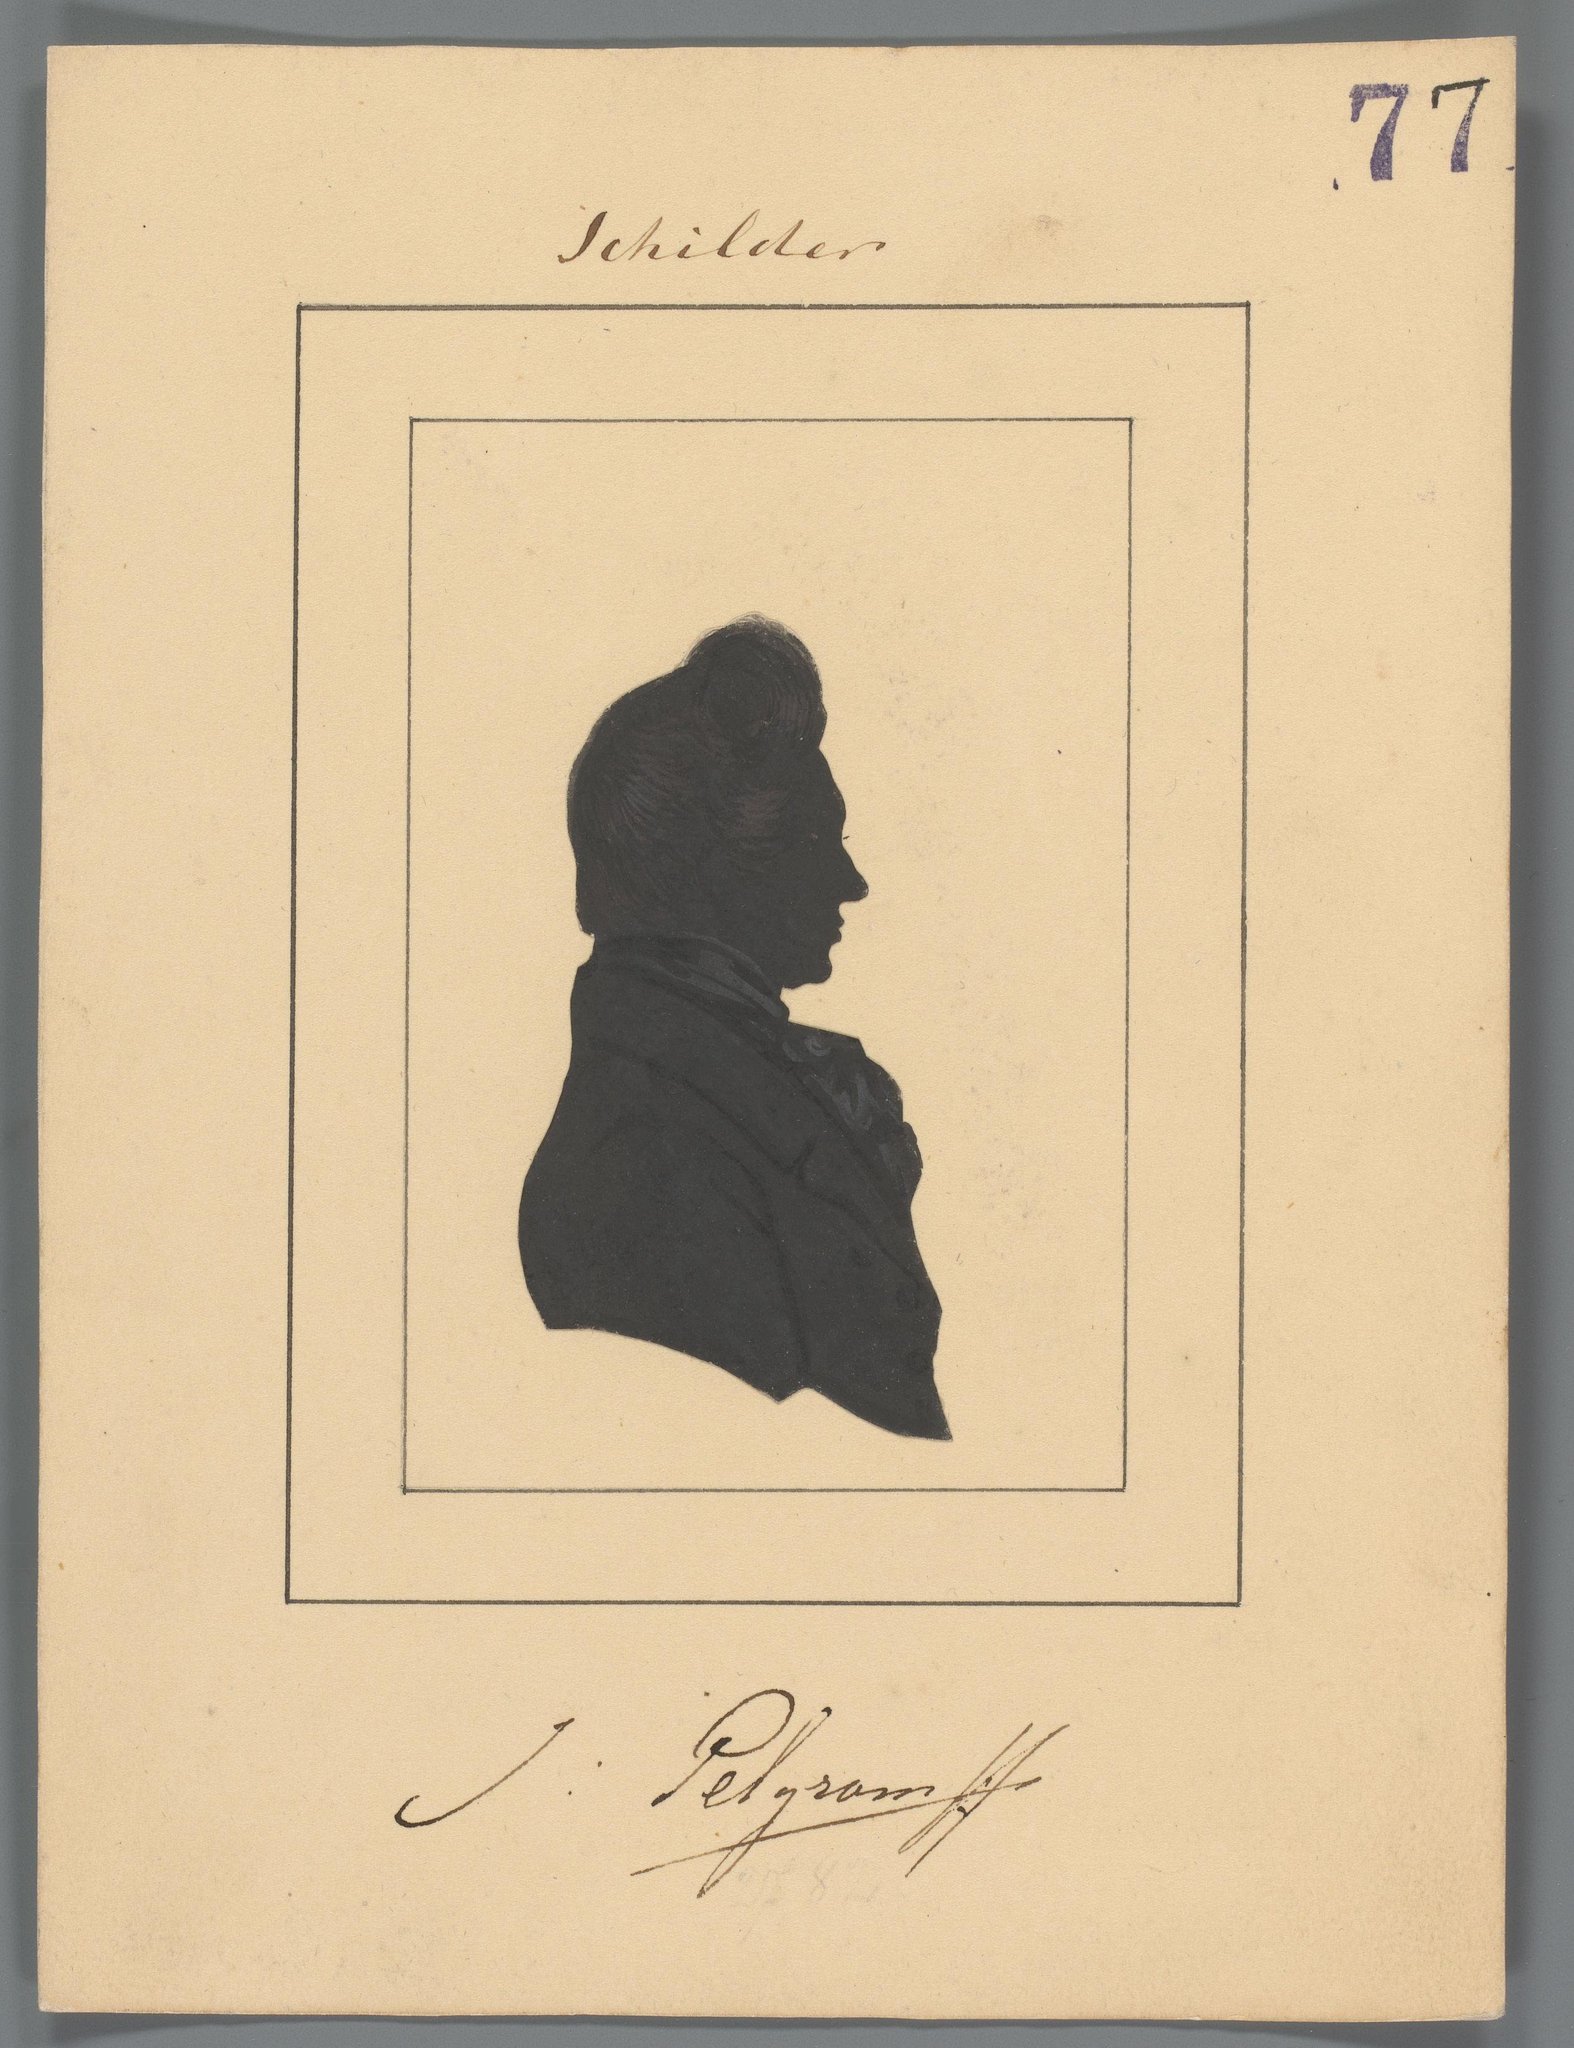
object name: drawing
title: Silhouetportret van Jacobus Pelgrom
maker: elisabeth alida haanen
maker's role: draughtsman, print maker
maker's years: 1809-1845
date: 1819-1845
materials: ink, paint, paper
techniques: brush, snipping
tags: amsterdam, draughtsman, jacobus pelgrom, historical persons, portrait, self-portrait of painter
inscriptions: inscription: ‘Schilder’, number: ‘77’, inscription: ‘J: Pelgrom’, number: ‘13980’, collector's mark: ‘Ex-libris van Beresteyn’, inscription: ‘Neg. D. 1791’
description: Met onder het portret de handtekening van de geportretteerde.